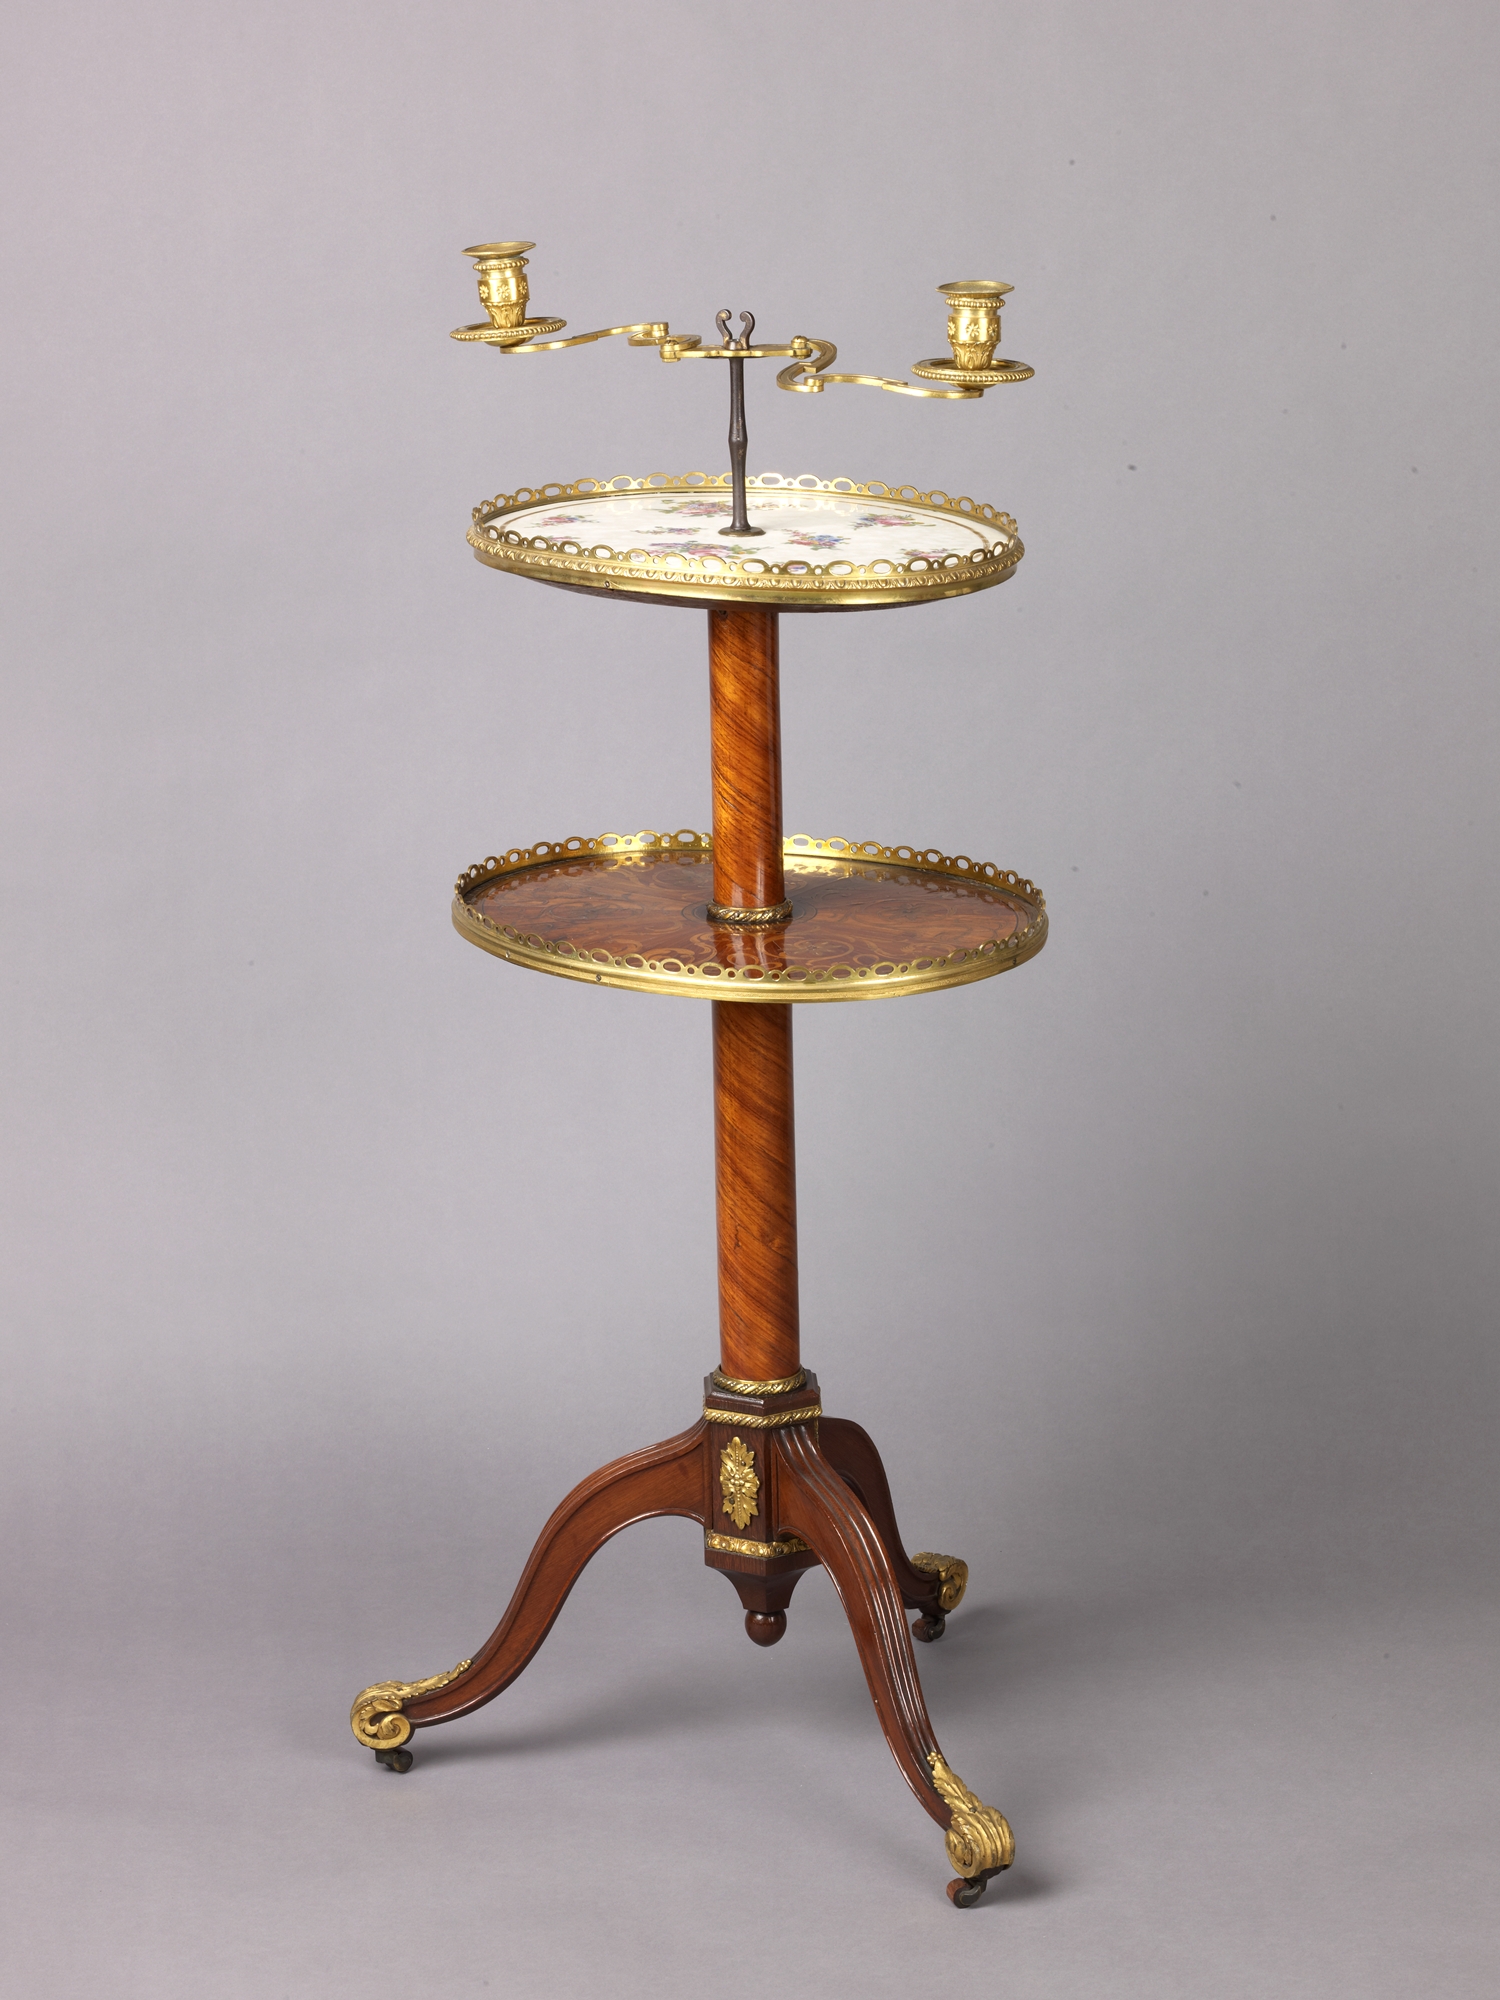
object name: candle stand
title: Candlestand and holder (guéridon)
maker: martin carlin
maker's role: artist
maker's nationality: french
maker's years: 1725-1785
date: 1730-1785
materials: wood, gilt bronze, steel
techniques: veneering